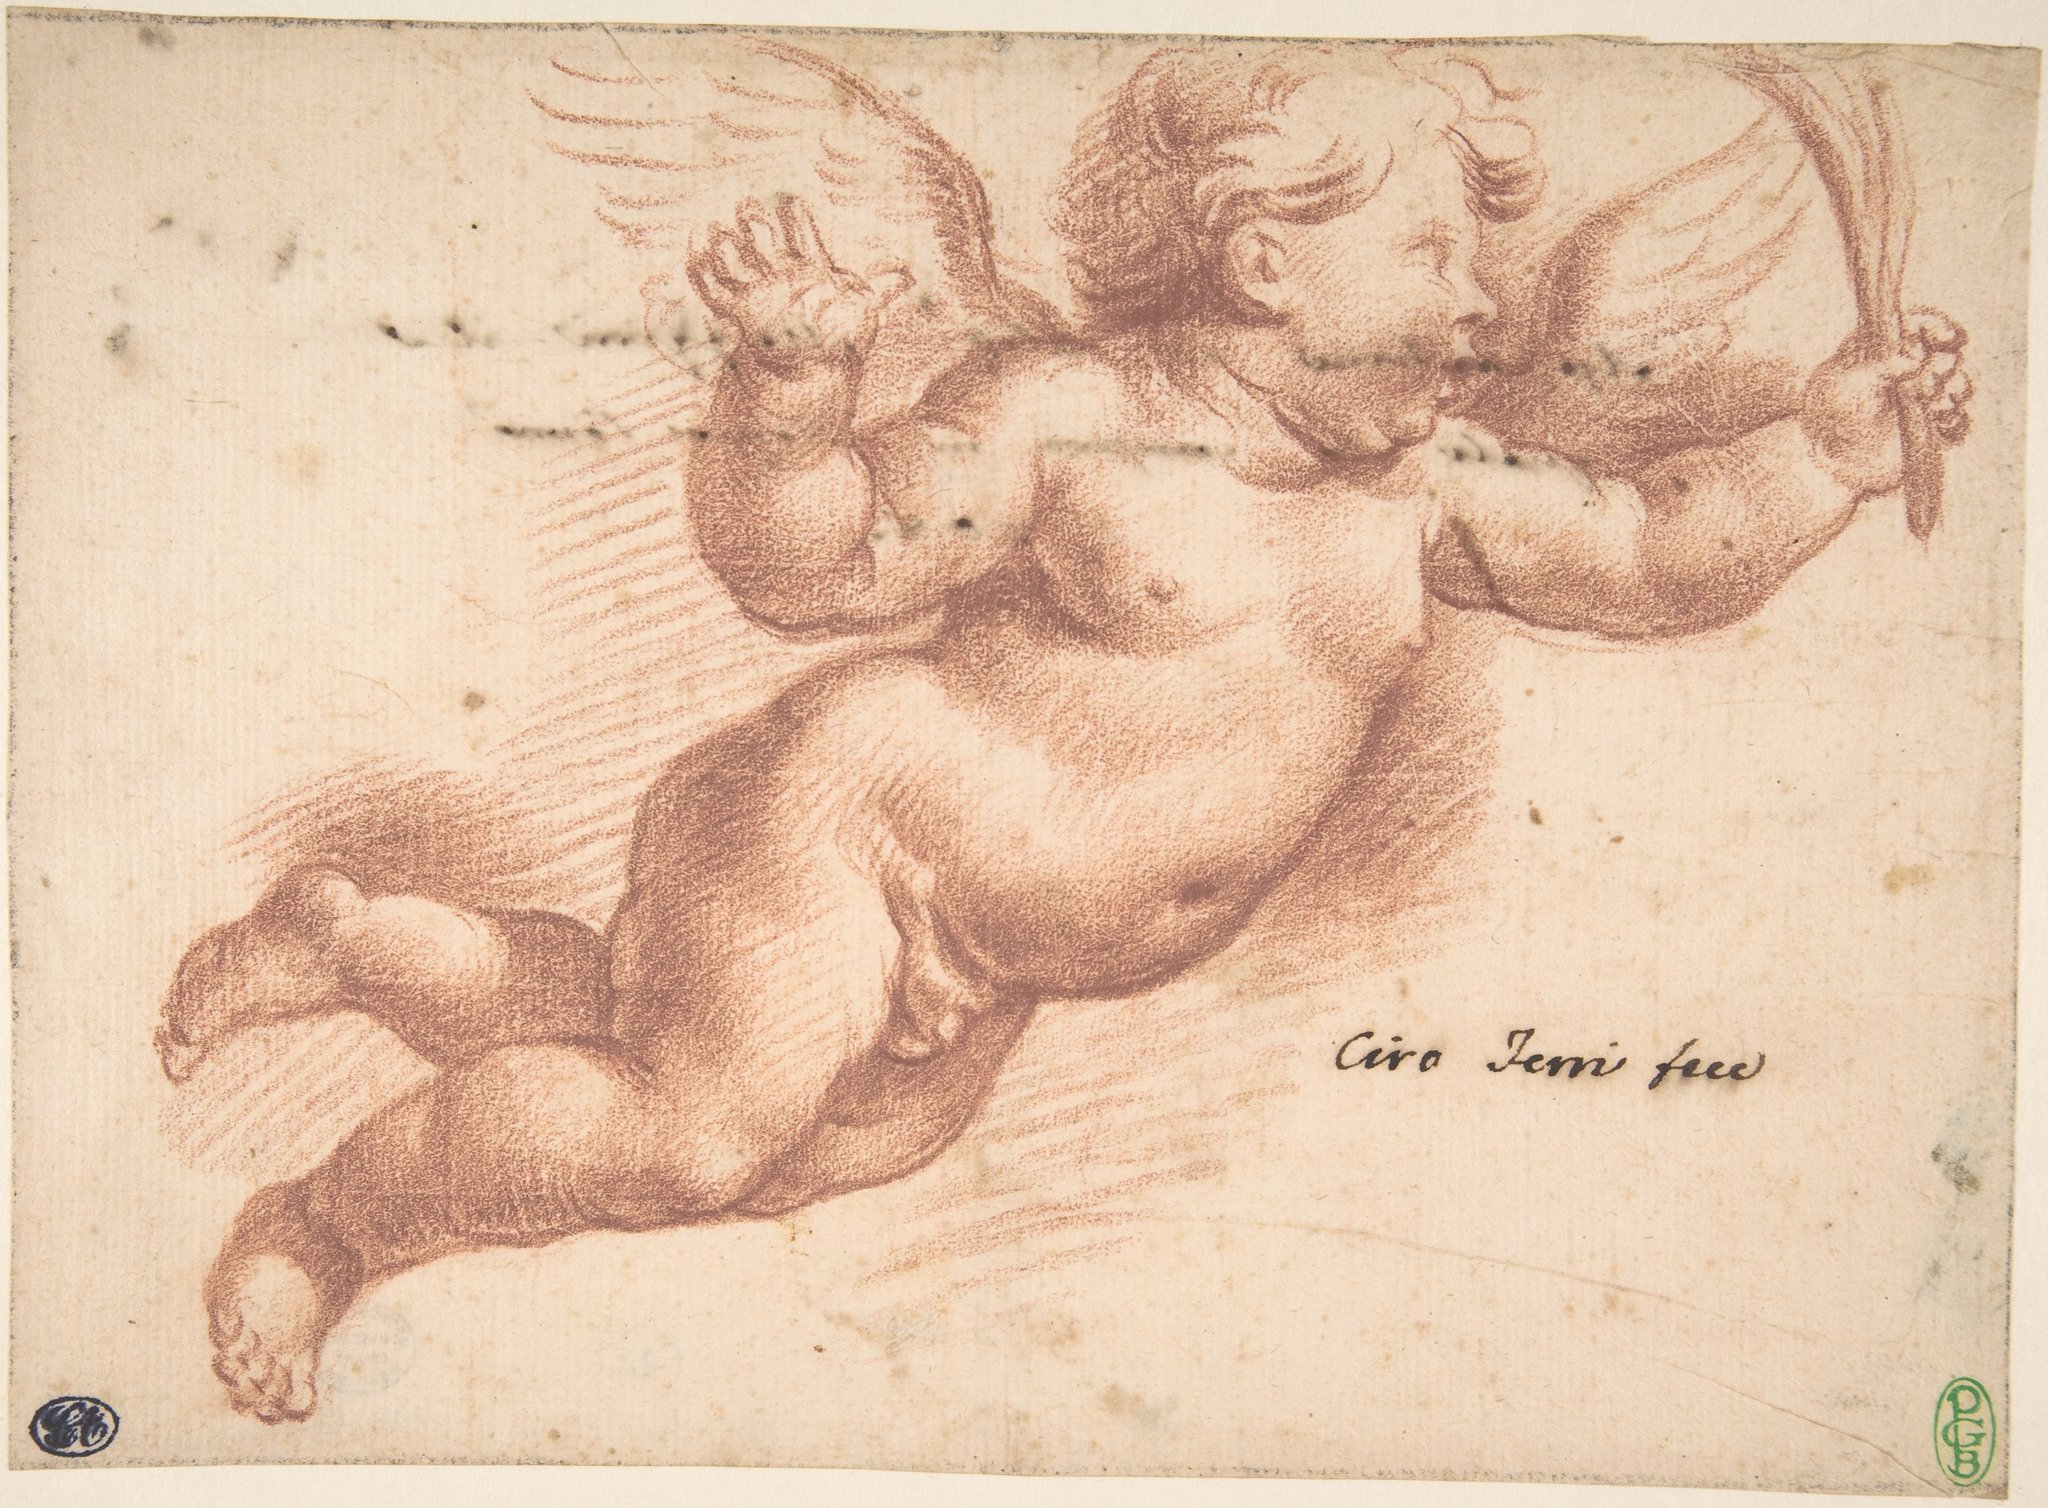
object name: drawing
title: Flying Putto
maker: ciro ferri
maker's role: artist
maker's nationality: italian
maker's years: 1634-1689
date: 1634-1689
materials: chalk